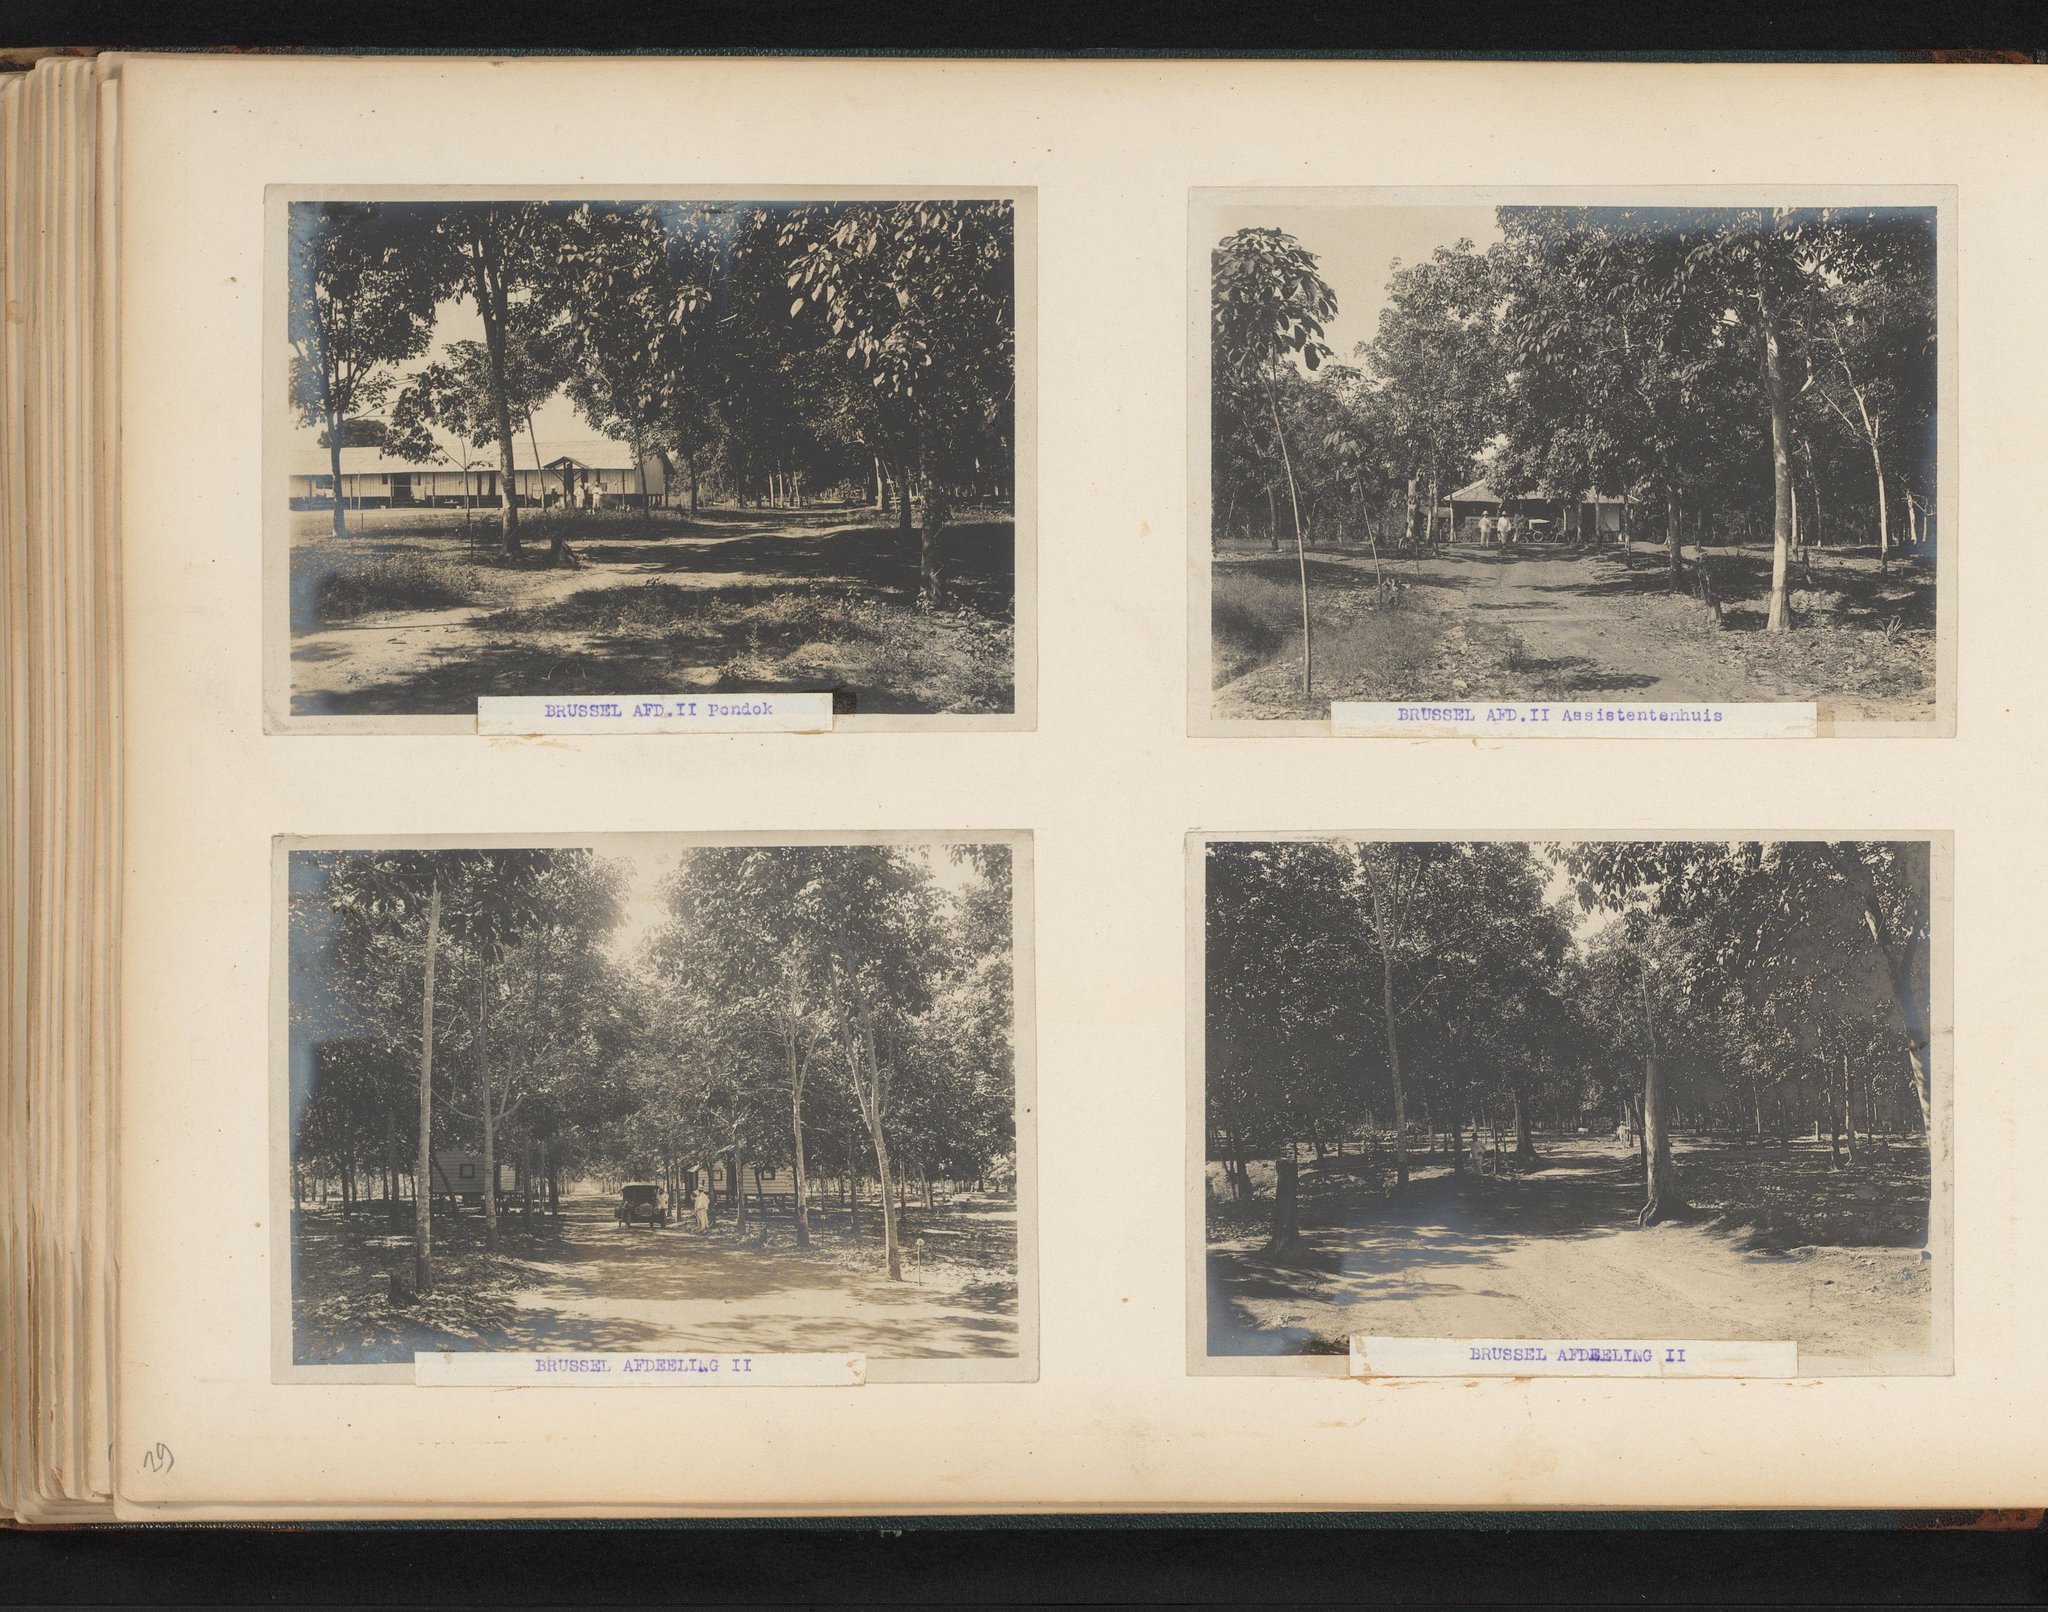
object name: photograph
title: Rubberbomen en gebouwen op Brussel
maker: Anonymous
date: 1913-1924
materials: cardboard, photographic support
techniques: gelatin silver print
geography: east sumatra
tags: plantation, (non-fruit) products of plants or trees: rubber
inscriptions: inscription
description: Blad met vier foto's van rubberbomen en enkele bedrijfsgebouwen op plantage Brussel. Onder de foto's etiketten met onderschriften. Onderdeel van het fotoalbum over de plantages Brussel en Pernantian van de Sumatra Caoutchouc Maatschappij op de Oostkust van Sumatra in de jaren 1910-1935.